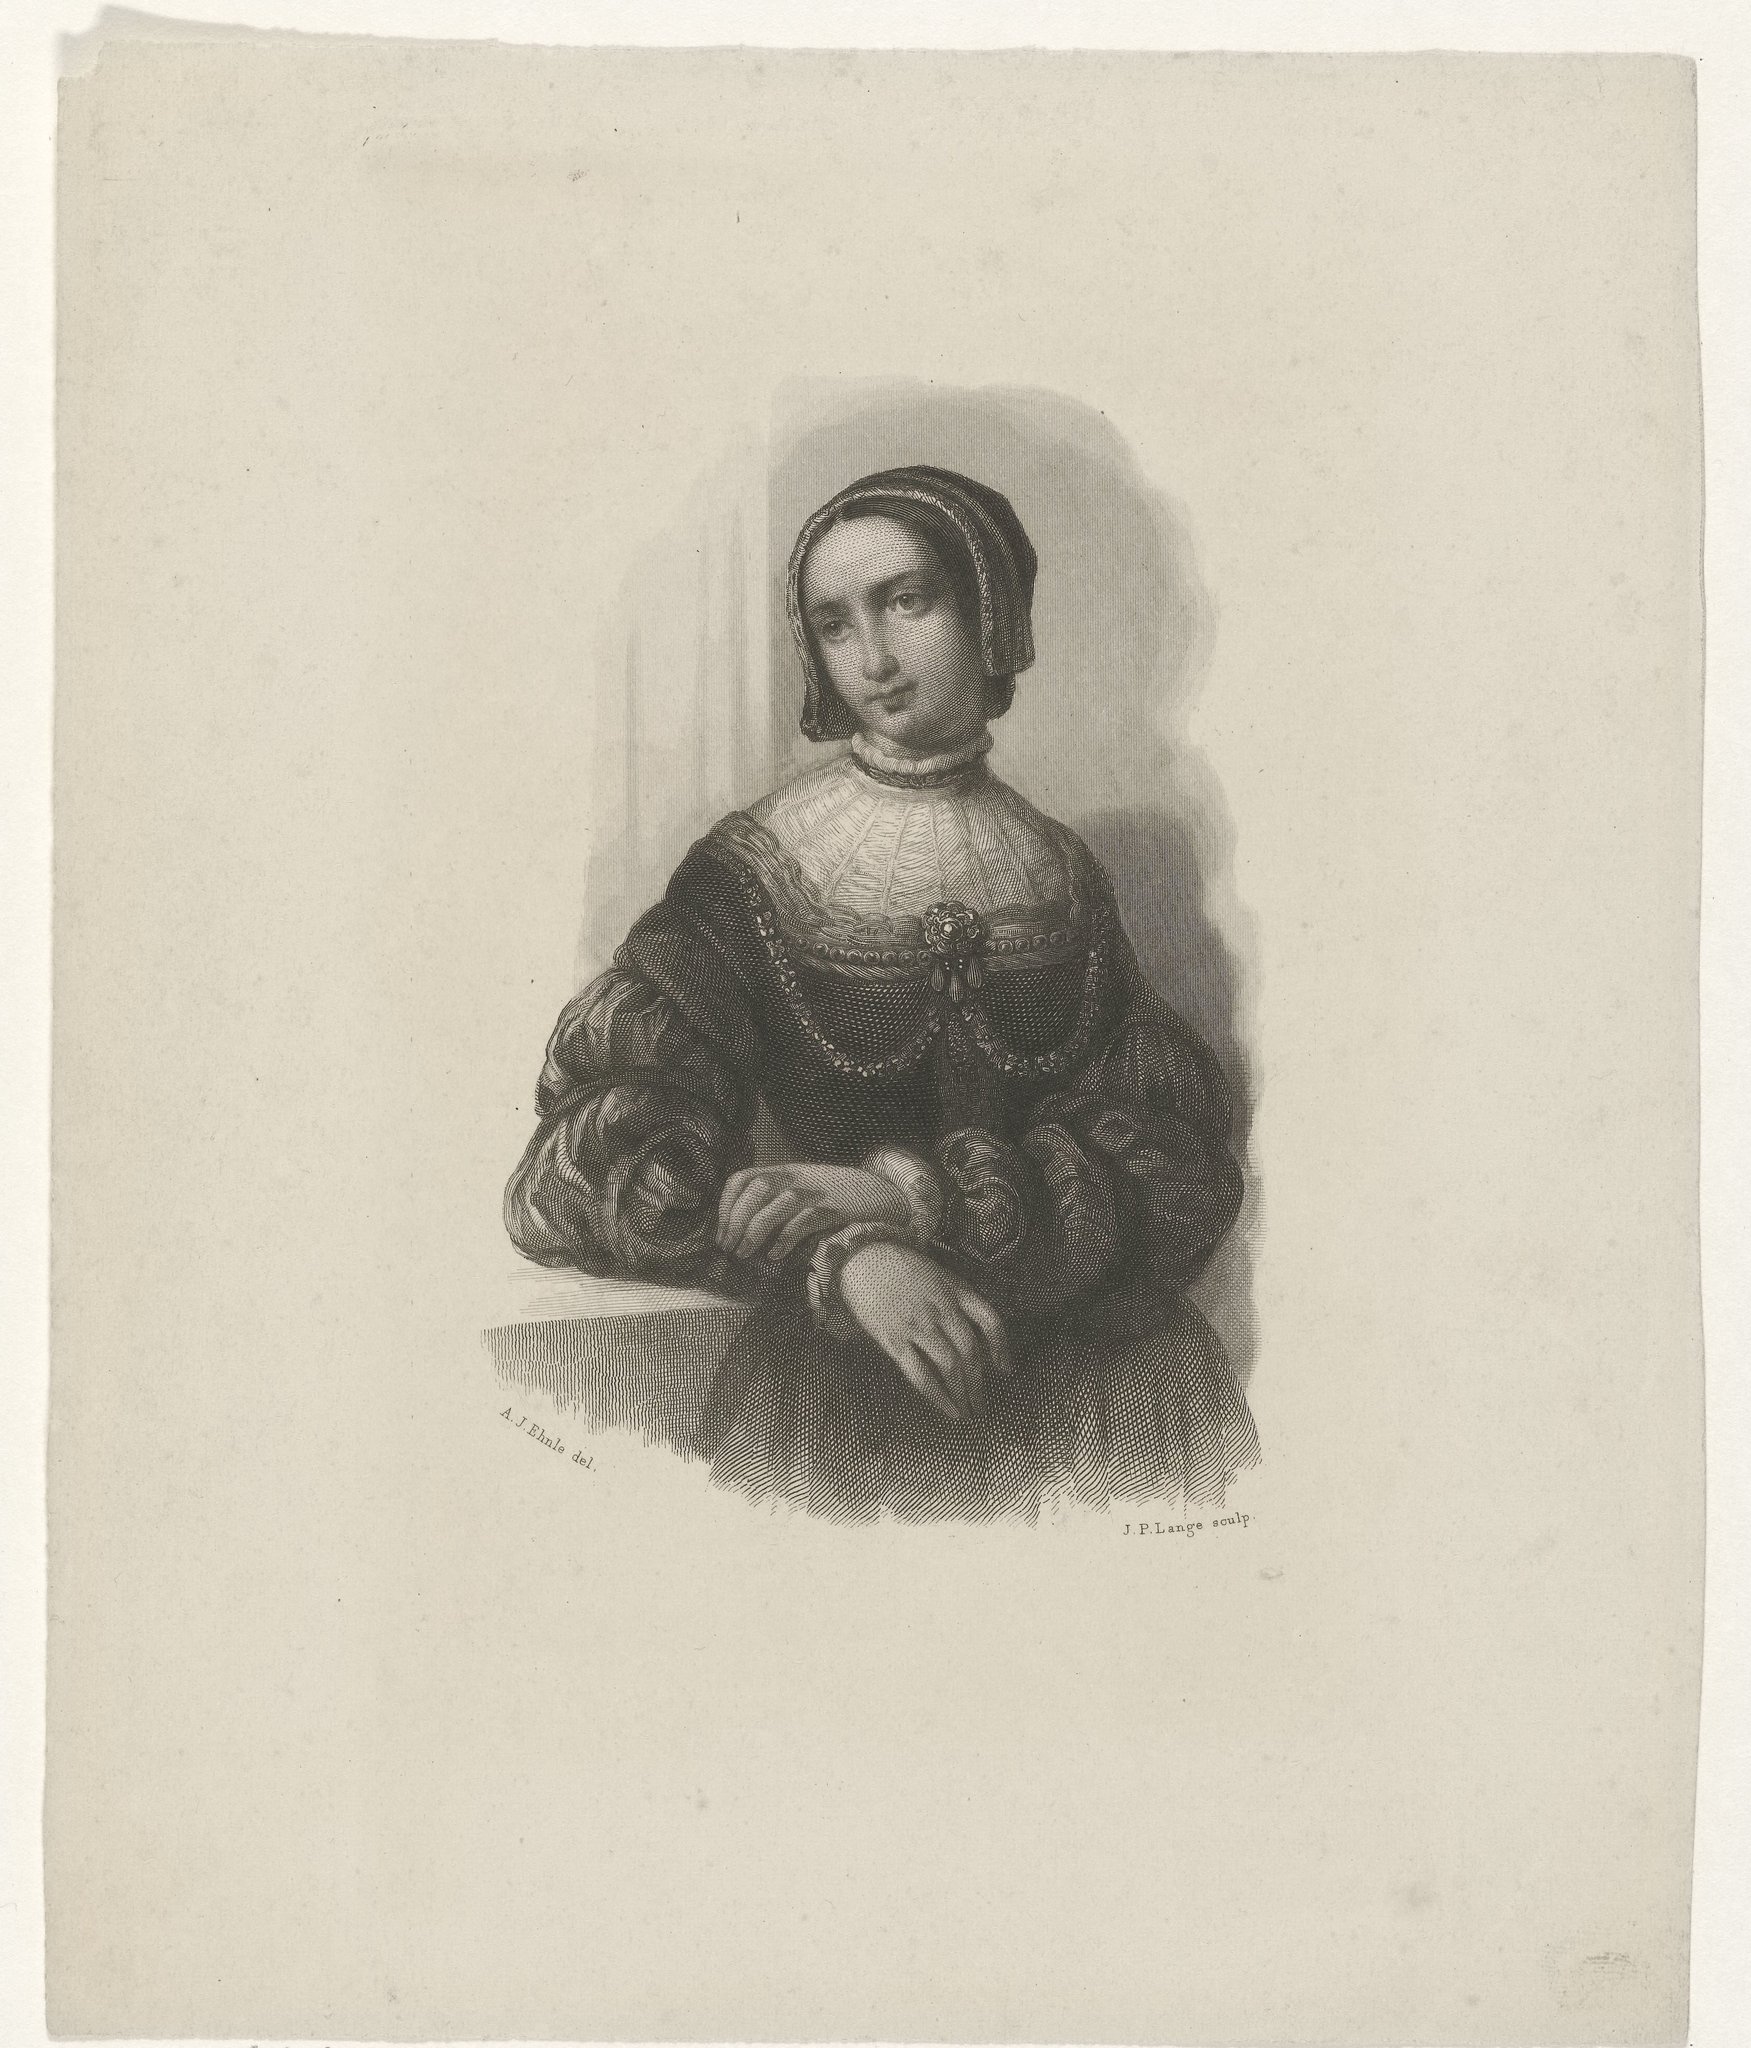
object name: print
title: Portret van een onbekende jonge vrouw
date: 1829-1849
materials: paper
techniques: engraving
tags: anonymous historical person portrayed alone - bb - woman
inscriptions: collector's mark: Lugt 2228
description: Een onbekende jonge vrouw, het hoofd driekwart naar links gedraaid en bedekt met een kapje, staand bijeen venster.